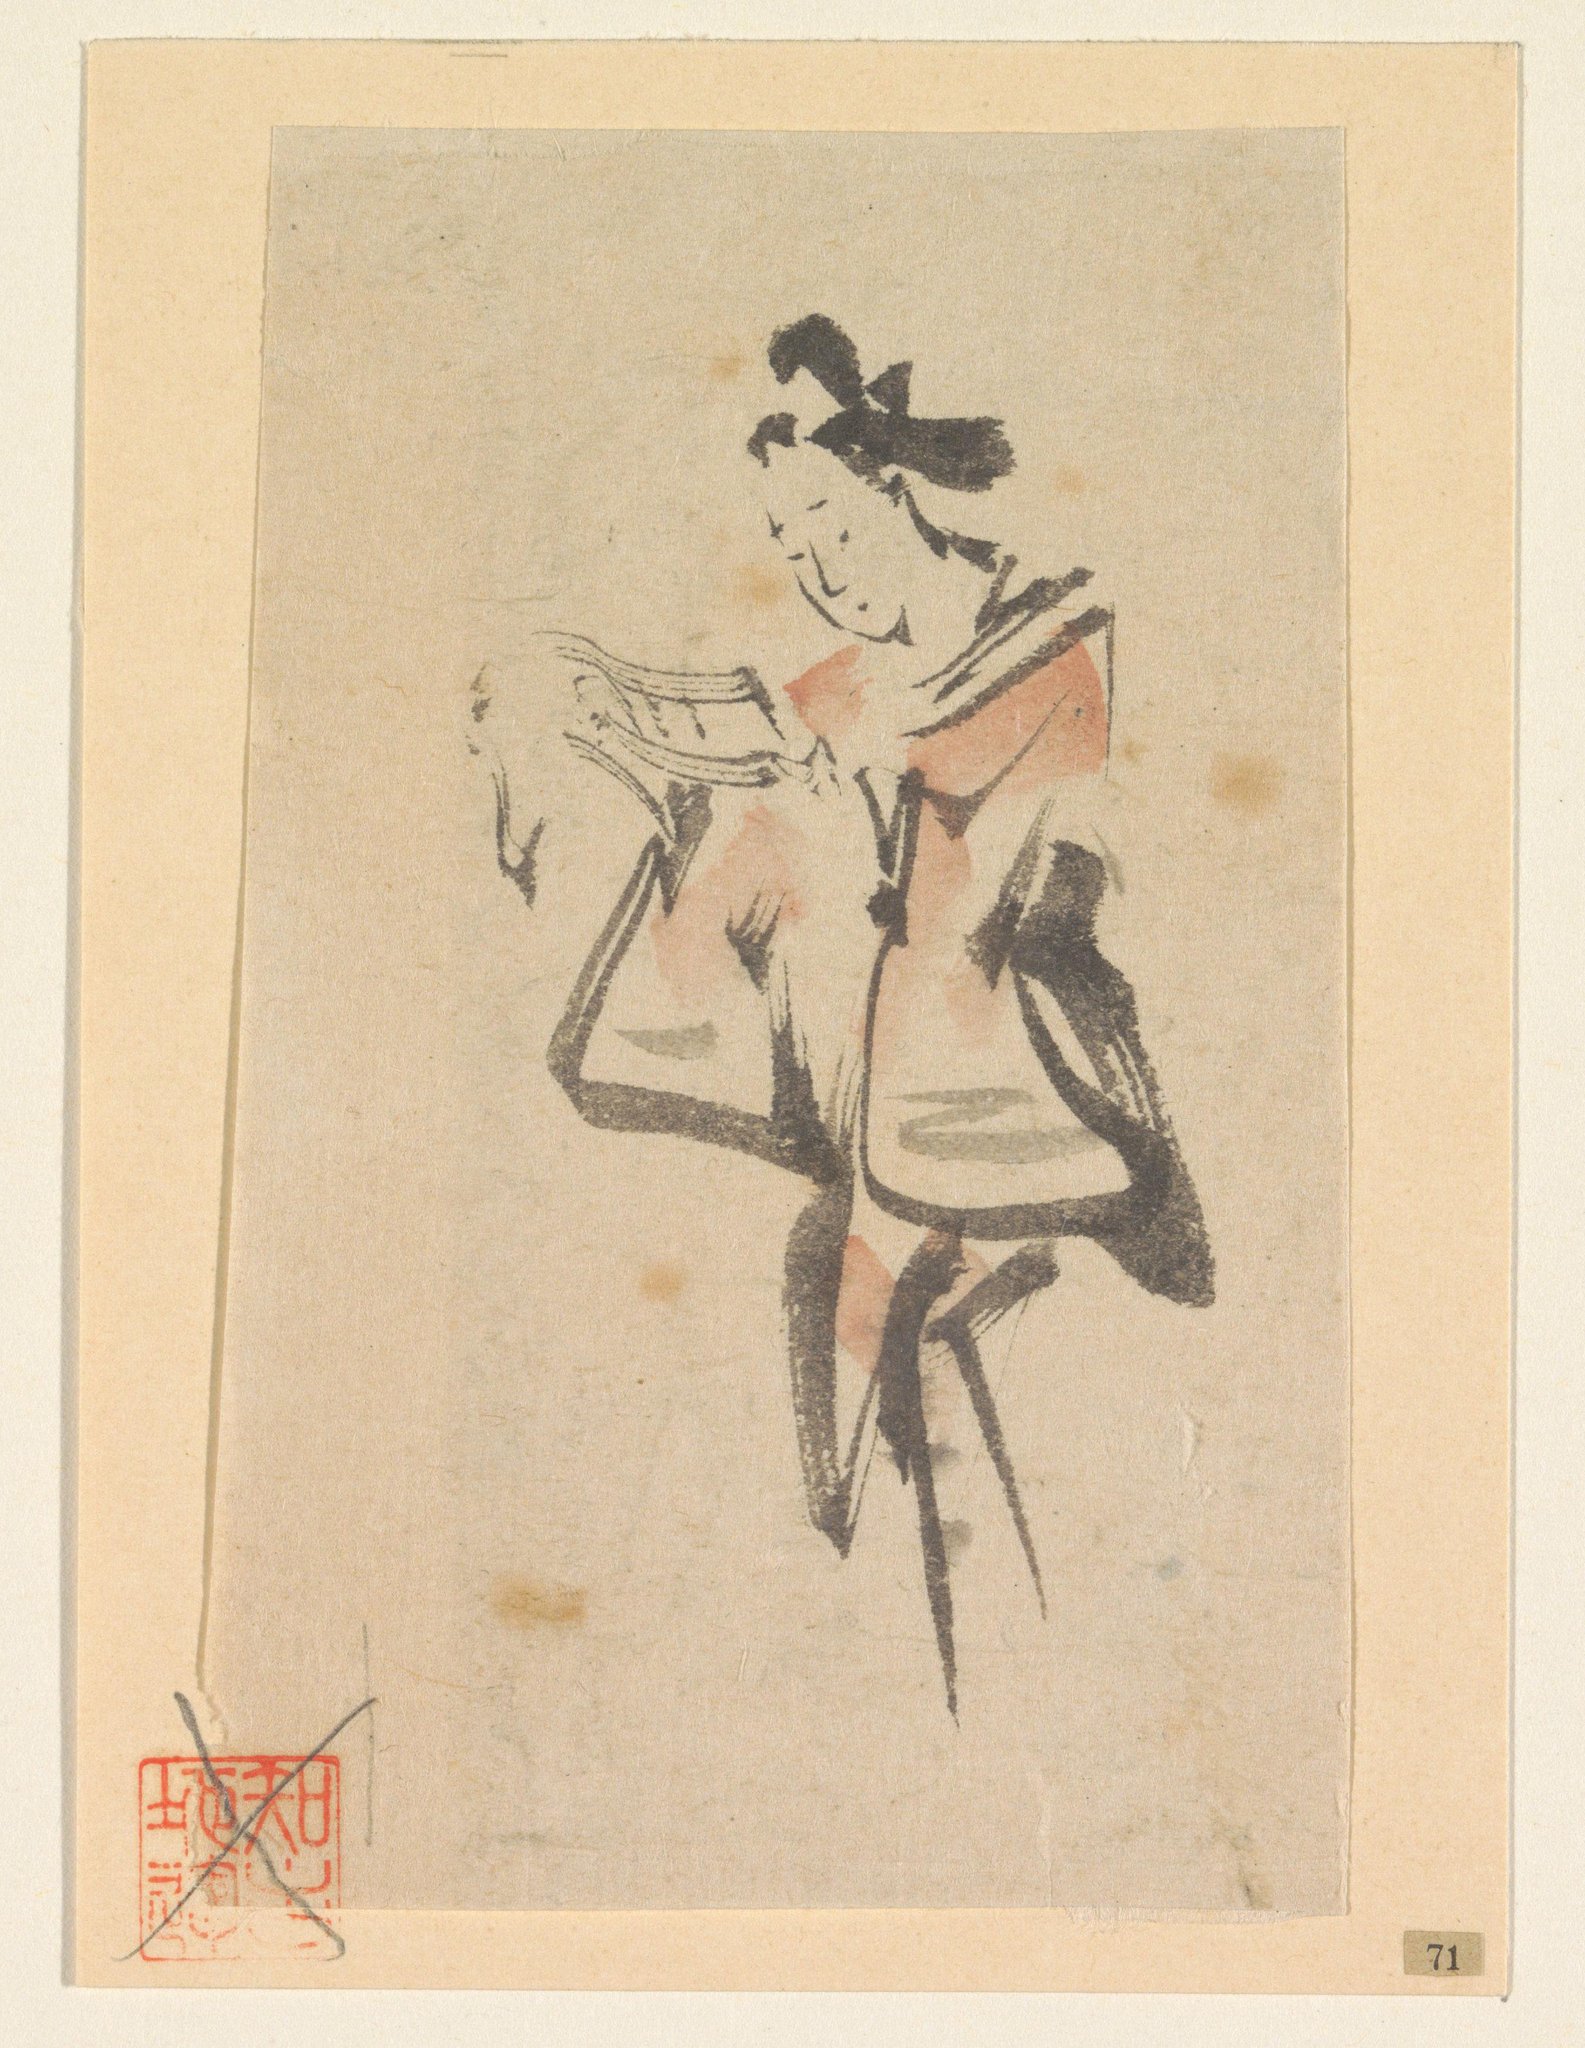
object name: drawing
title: Schets van een lezende vrouw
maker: Anonymous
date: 1800-1900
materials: paper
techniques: brush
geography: japan